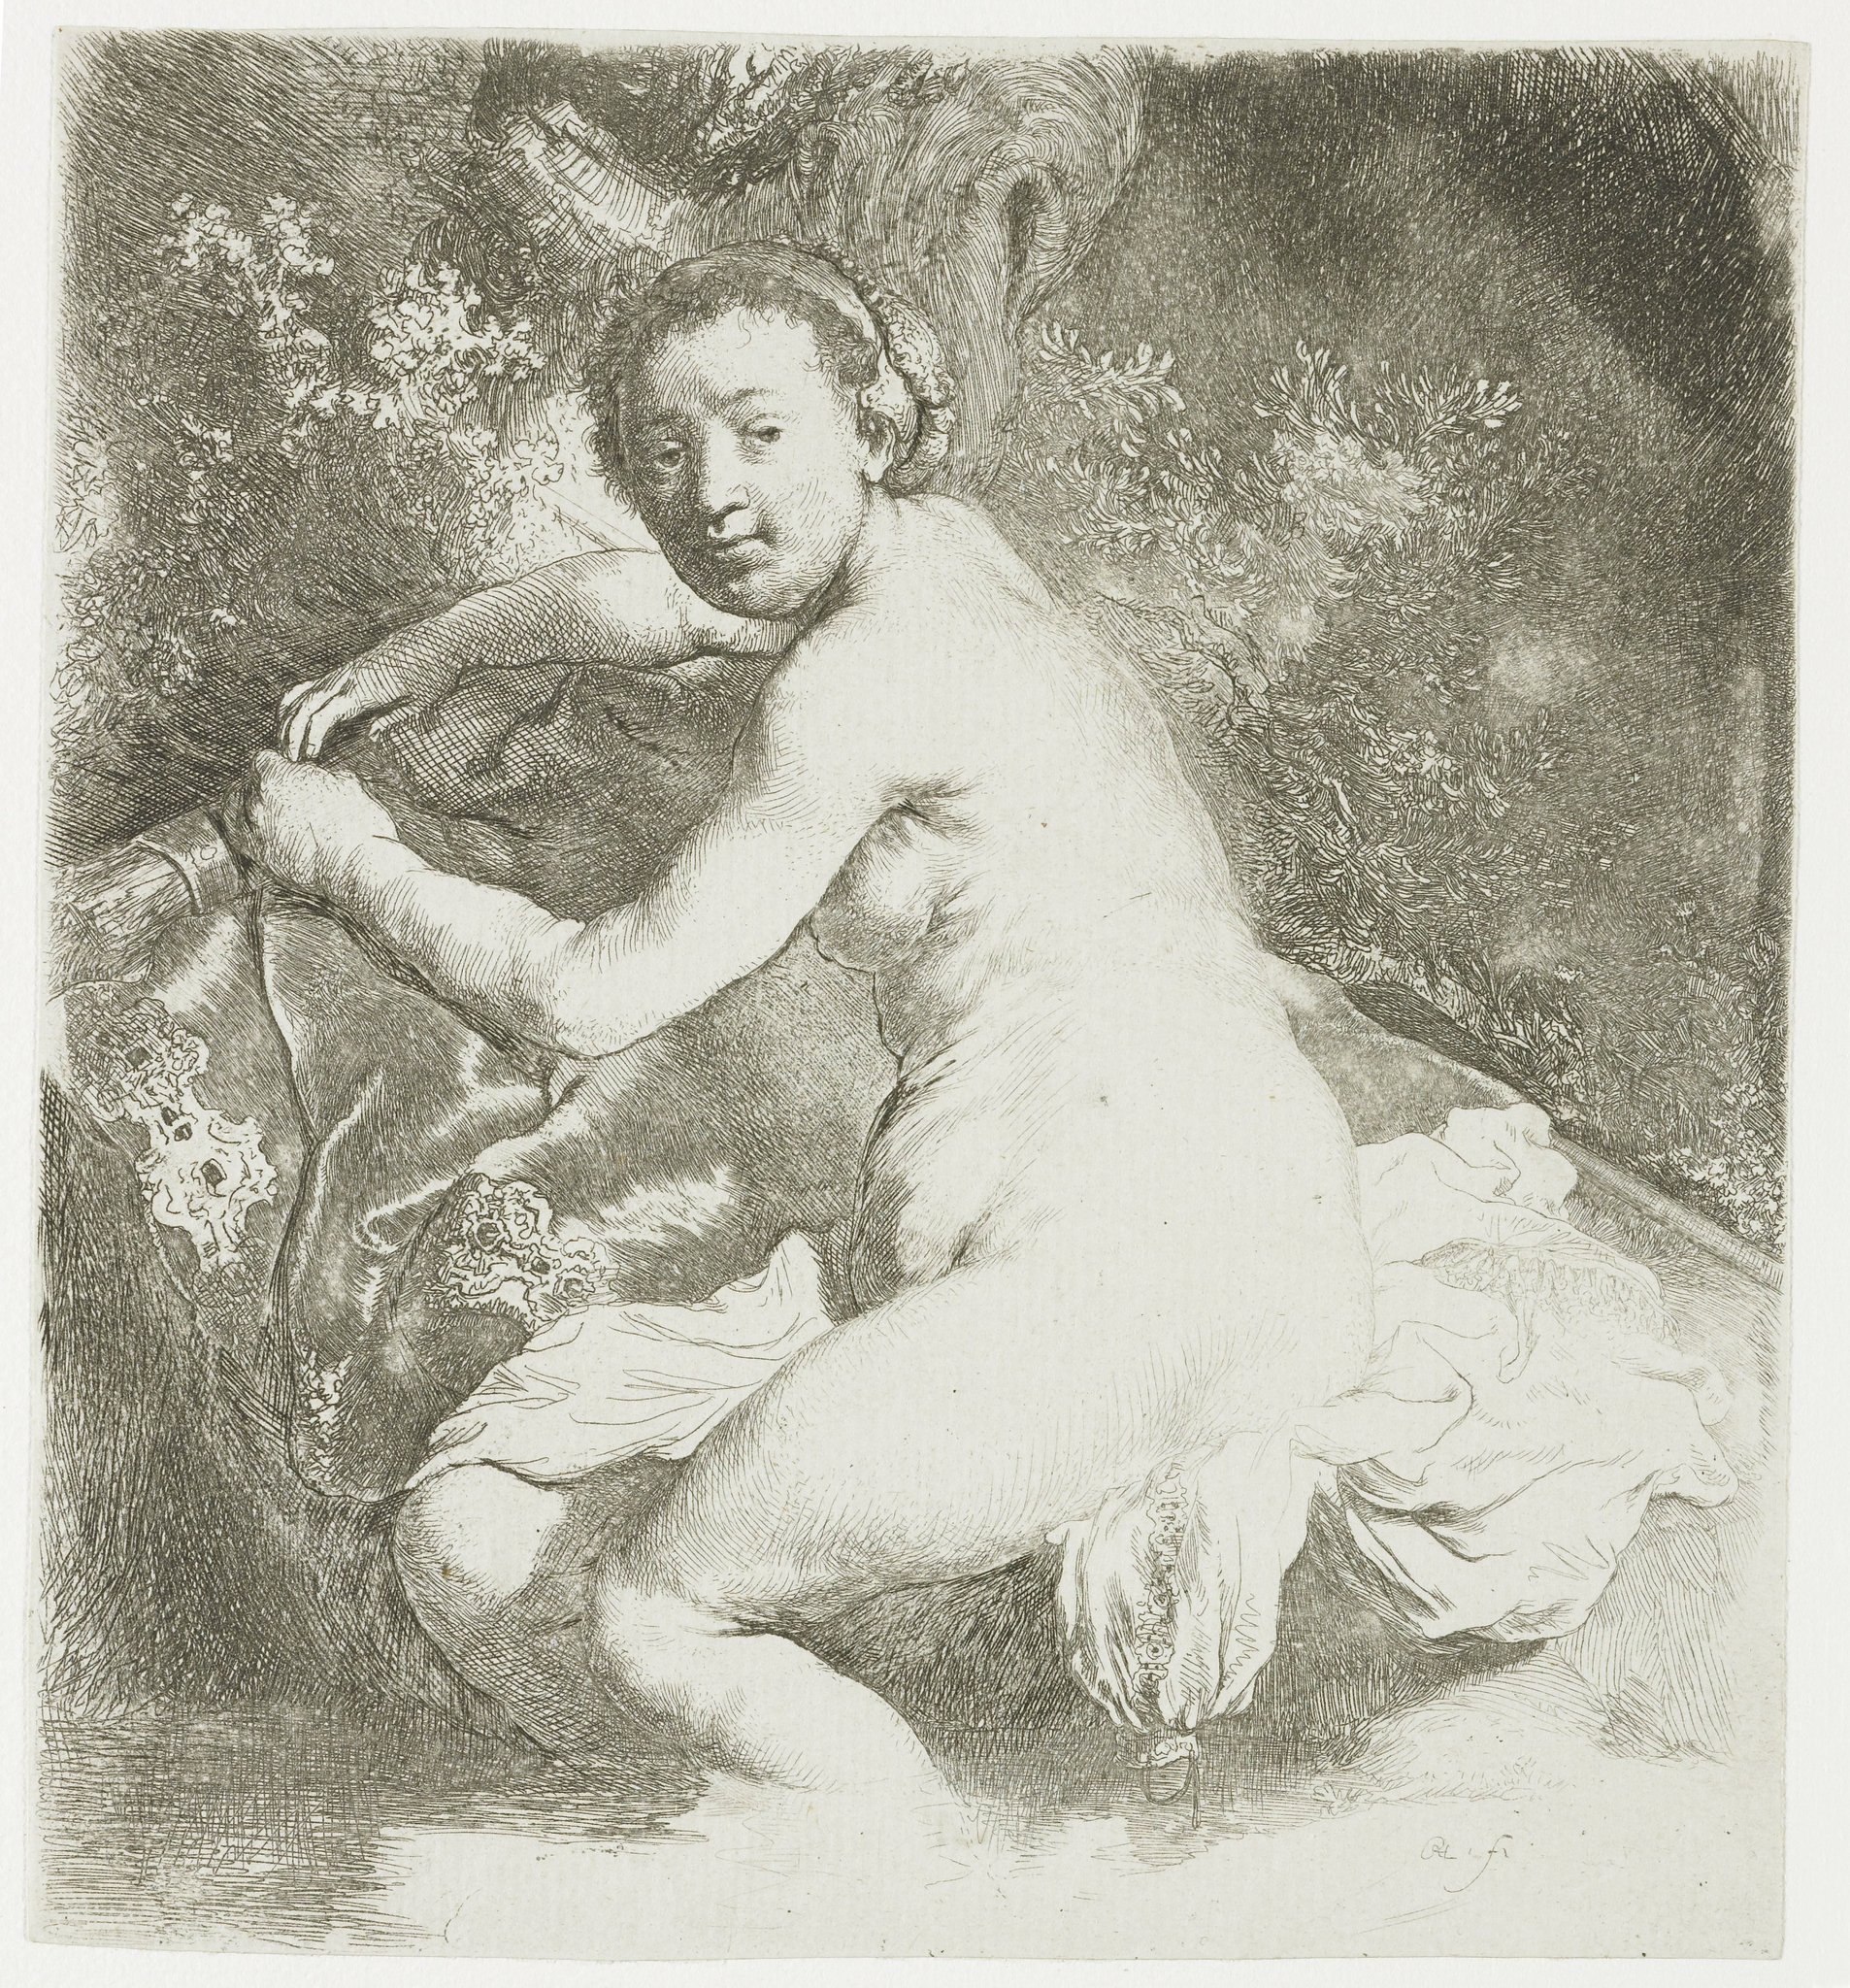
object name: print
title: Diana at the bath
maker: rembrandt van rijn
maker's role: draughtsman, painter, print maker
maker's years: 1606-1669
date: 1631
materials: paper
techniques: etching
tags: (story of) diana (artemis)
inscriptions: collector's mark: Lugt 2165, monogram: ‘RHL.f.’